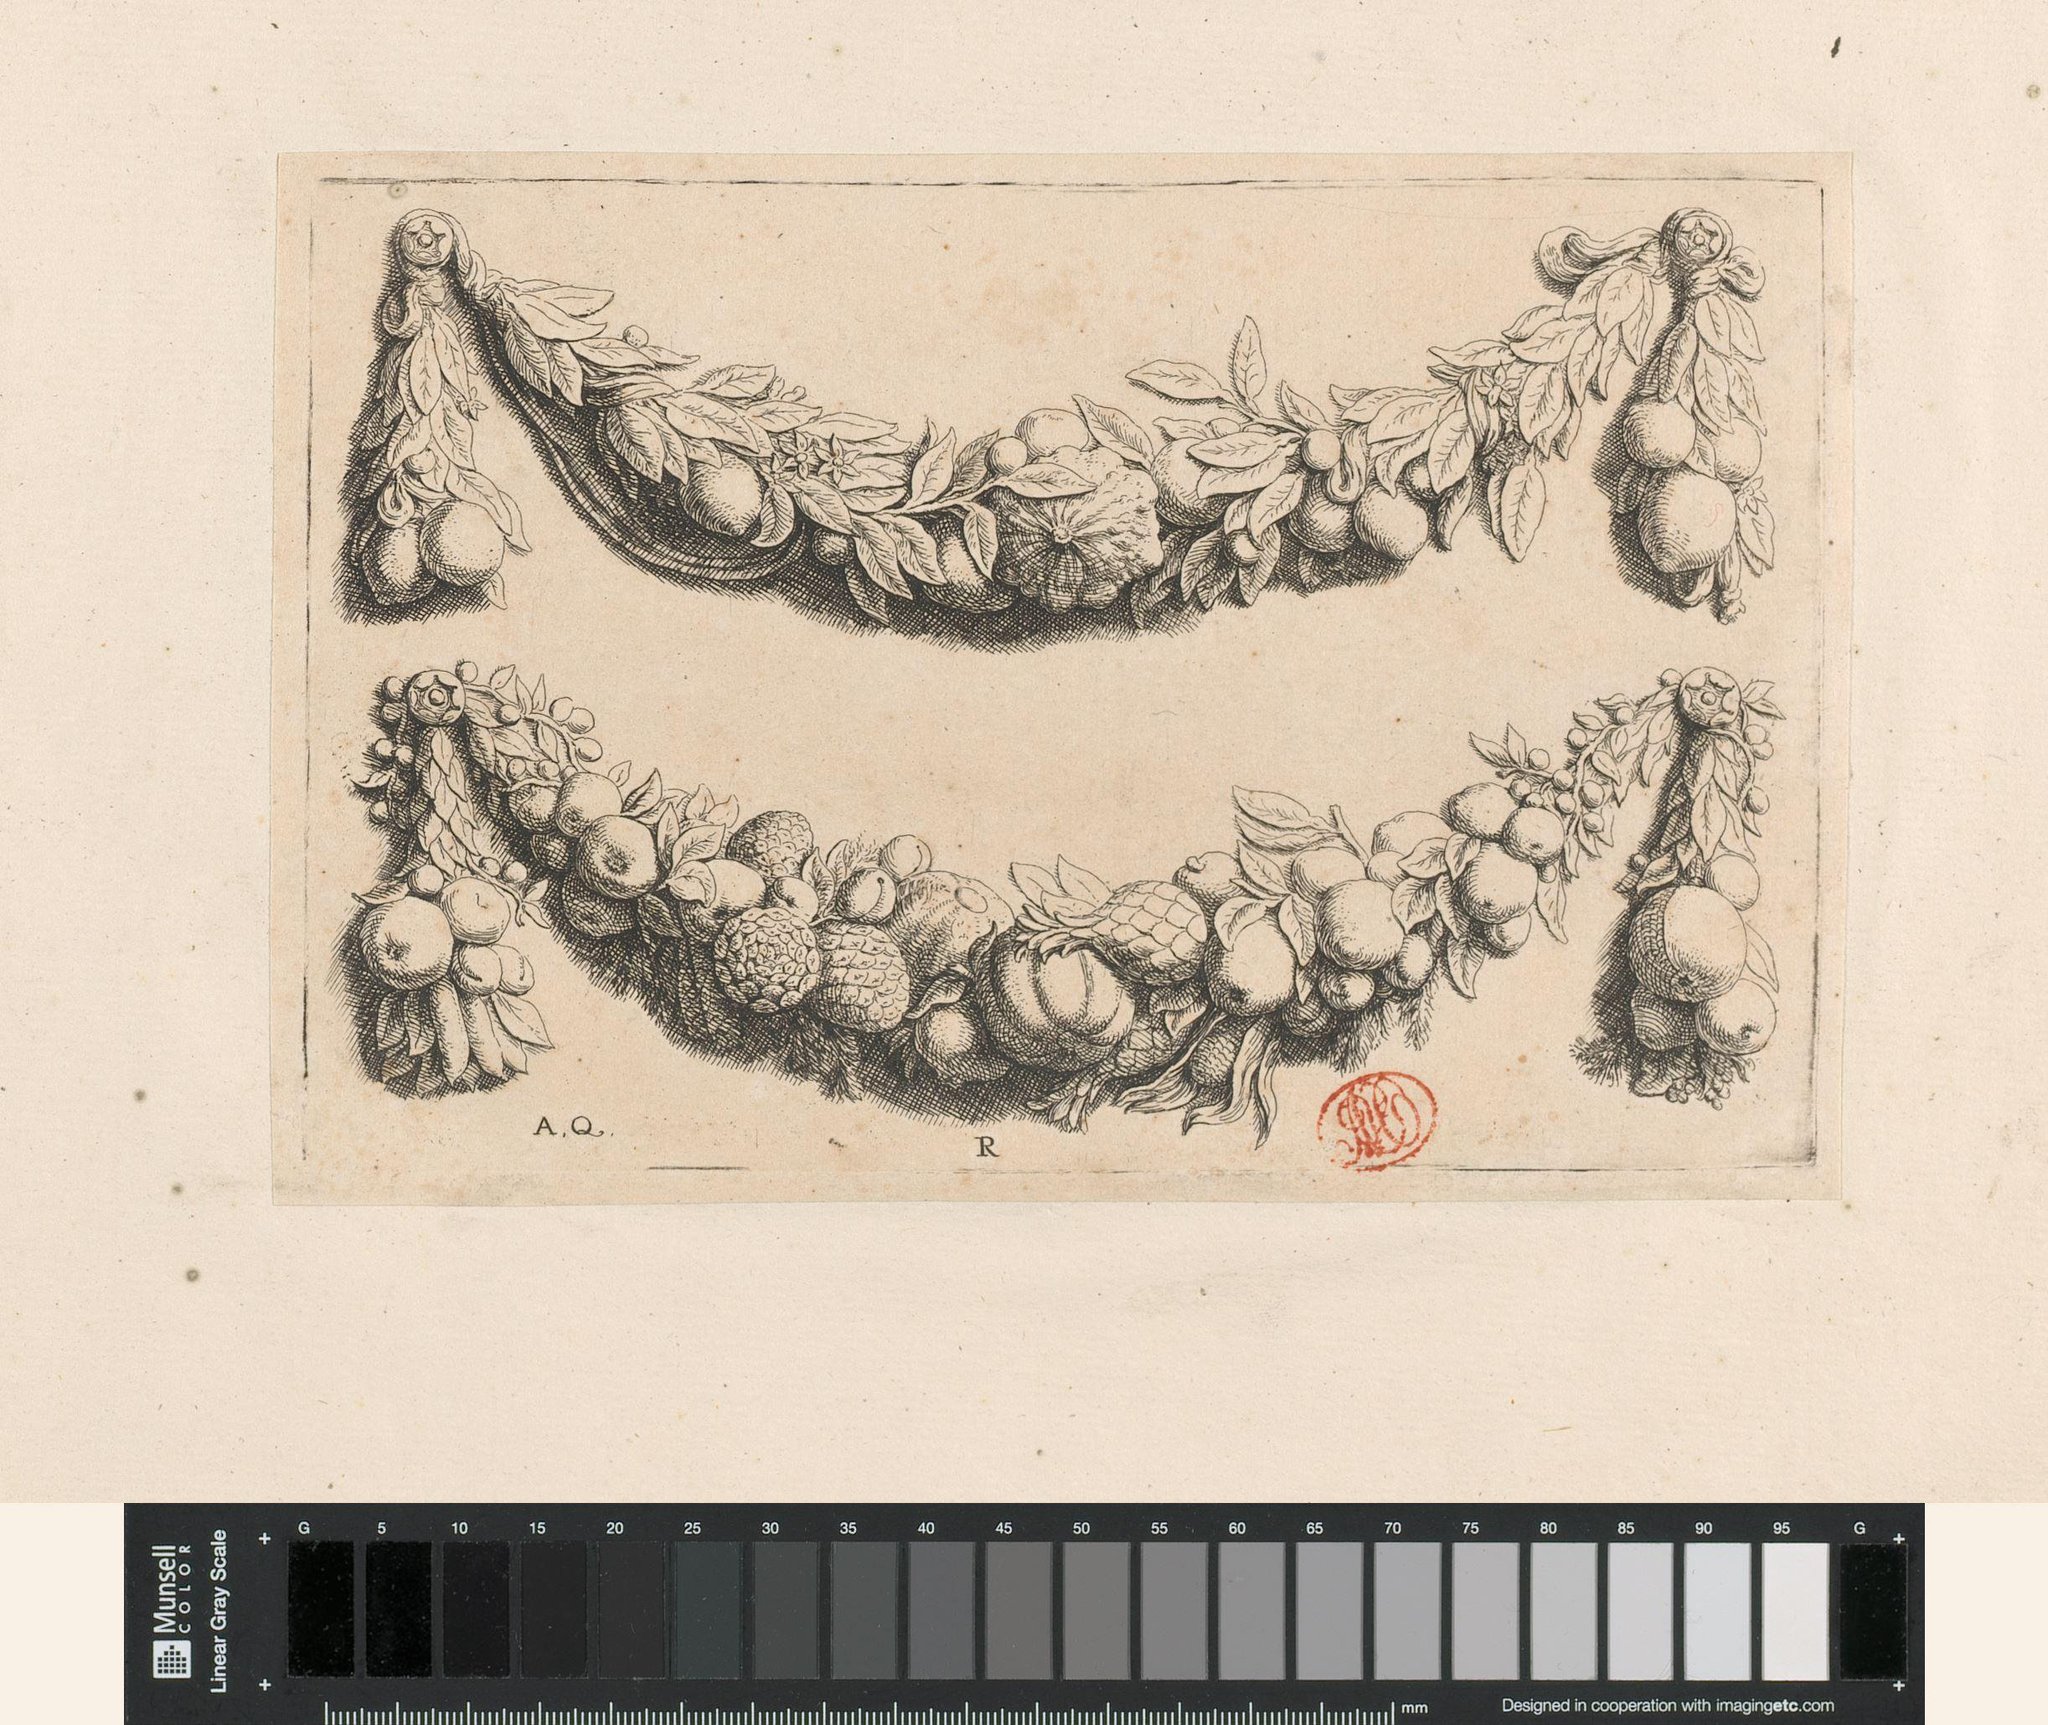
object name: print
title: Twee festoenen met fruit en bladeren in de oostelijke galerij van het Stadhuis op de Dam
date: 1655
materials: paper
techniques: engraving, etching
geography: amsterdam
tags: fruits and vegetables ~ ornament, ornament ~ festoon, garland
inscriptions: collector's mark: Lugt 195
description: Prent gebruikt in: Prima pars. Praecipuarum effigierum ac ornamentorum, amplissimae Curiae Amstelrodamensis (…) / Het eerste deel. Van de voornaemste Statuen ende Ciraten, vant konstijck Stadhuys van Amstelredam, tmeeste in marmer gemaeckt, door Artus Quellinus, Beelthouwer der voorseyde Stadt / La Premier Partie. De plusieurs Figures et ornements, de la Maison de Ville d'Amsterdam (…). Amsterdam: Artus Quellinus (I), 1655. Zie RP-P-AO-22-1-1 voor bijhorende titelpagina. Zie RP-P-AO-22-1-2 voor bijhorend register. Zie RP-P-AO-22-1A, RP-P-AO-22-1B, RP-P-AO-22-1C, RP-P-AO-22-1D-1, RP-P-AO-22-1D-2, RP-P-AO-22-1E, RP-P-AO-22-1F, RP-P-AO-22-1G, RP-P-AO-22-1H, RP-P-AO-22-1I, RP-P-AO-22-1K-1, RP-P-AO-22-1K-2, RP-P-AO-22-1K-3, RP-P-AO-22-1K-4, RP-P-AO-22-1K-5, RP-P-AO-22-1L-1, RP-P-AO-22-1L-2, RP-P-AO-22-1M-1, RP-P-AO-22-1M-2, RP-P-AO-22-1N-1, RP-P-AO-22-1N-2, RP-P-AO-22-1N-3, RP-P-AO-22-1N-4, RP-P-AO-22-1N-5, RP-P-AO-22-1O-1, RP-P-AO-22-1O-2, RP-P-AO-22-1O-3, RP-P-AO-22-1O-4, RP-P-AO-22-1P-1, RP-P-AO-22-1P-2, RP-P-AO-22-1P-3, RP-P-AO-22-1P-4, RP-P-AO-22-1Q-1, RP-P-AO-22-1Q-2, RP-P-AO-22-1Q-3, RP-P-AO-22-1Q-4, RP-P-AO-22-1R-1, RP-P-AO-22-1R-2, RP-P-AO-22-1R-3, RP-P-AO-22-1R-5, RP-P-AO-22-1S-1, RP-P-AO-22-1S-2, RP-P-AO-22-1S-3, RP-P-AO-22-1S-4, RP-P-AO-22-1S-5, RP-P-AO-22-1T-1 en RP-P-AO-22-1T-2 voor andere prenten uit deze publicatie. Zelfde staat van prent ook gebruikt in: Prima pars. Praecipuarum effigierum ac ornamentorum, amplissimae Curiae Amstelrodamensis (…) / Het eerste deel. Van de voornaemste Statuen ende Ciraten, vant konstijck Stadhuys van Amstelredam, tmeeste in marmer gemaeckt, door Artus Quellinus, Beelthouwer der voorseyde Stadt / La Premier Partie. De plusieurs Figures et ornements, de la Maison de Ville d'Amsterdam (…). Amsterdam: Frederik de Wit, 1665. Latere staat van prent ook gebruikt in: Architecture peinture et sculpture de la Maison de Ville d'Amsterdam, representee en CIX. figures en taille-douce (…). Amsterdam: David Mortier, 1719. En in: Architecture peinture et sculpture de la Maison de Ville d'Amsterdam, representee en CIX. figures en taille-douce (…). Amsterdam: Gerard Valck, 1719. En in: Bouw schilder en beeldhouwkonst, van het Stadhuis te Amsteldam, vertoont in CIX figuuren (…). Amsterdam: Covens & Mortier & Covens Jr., s.a. (1774-1783).